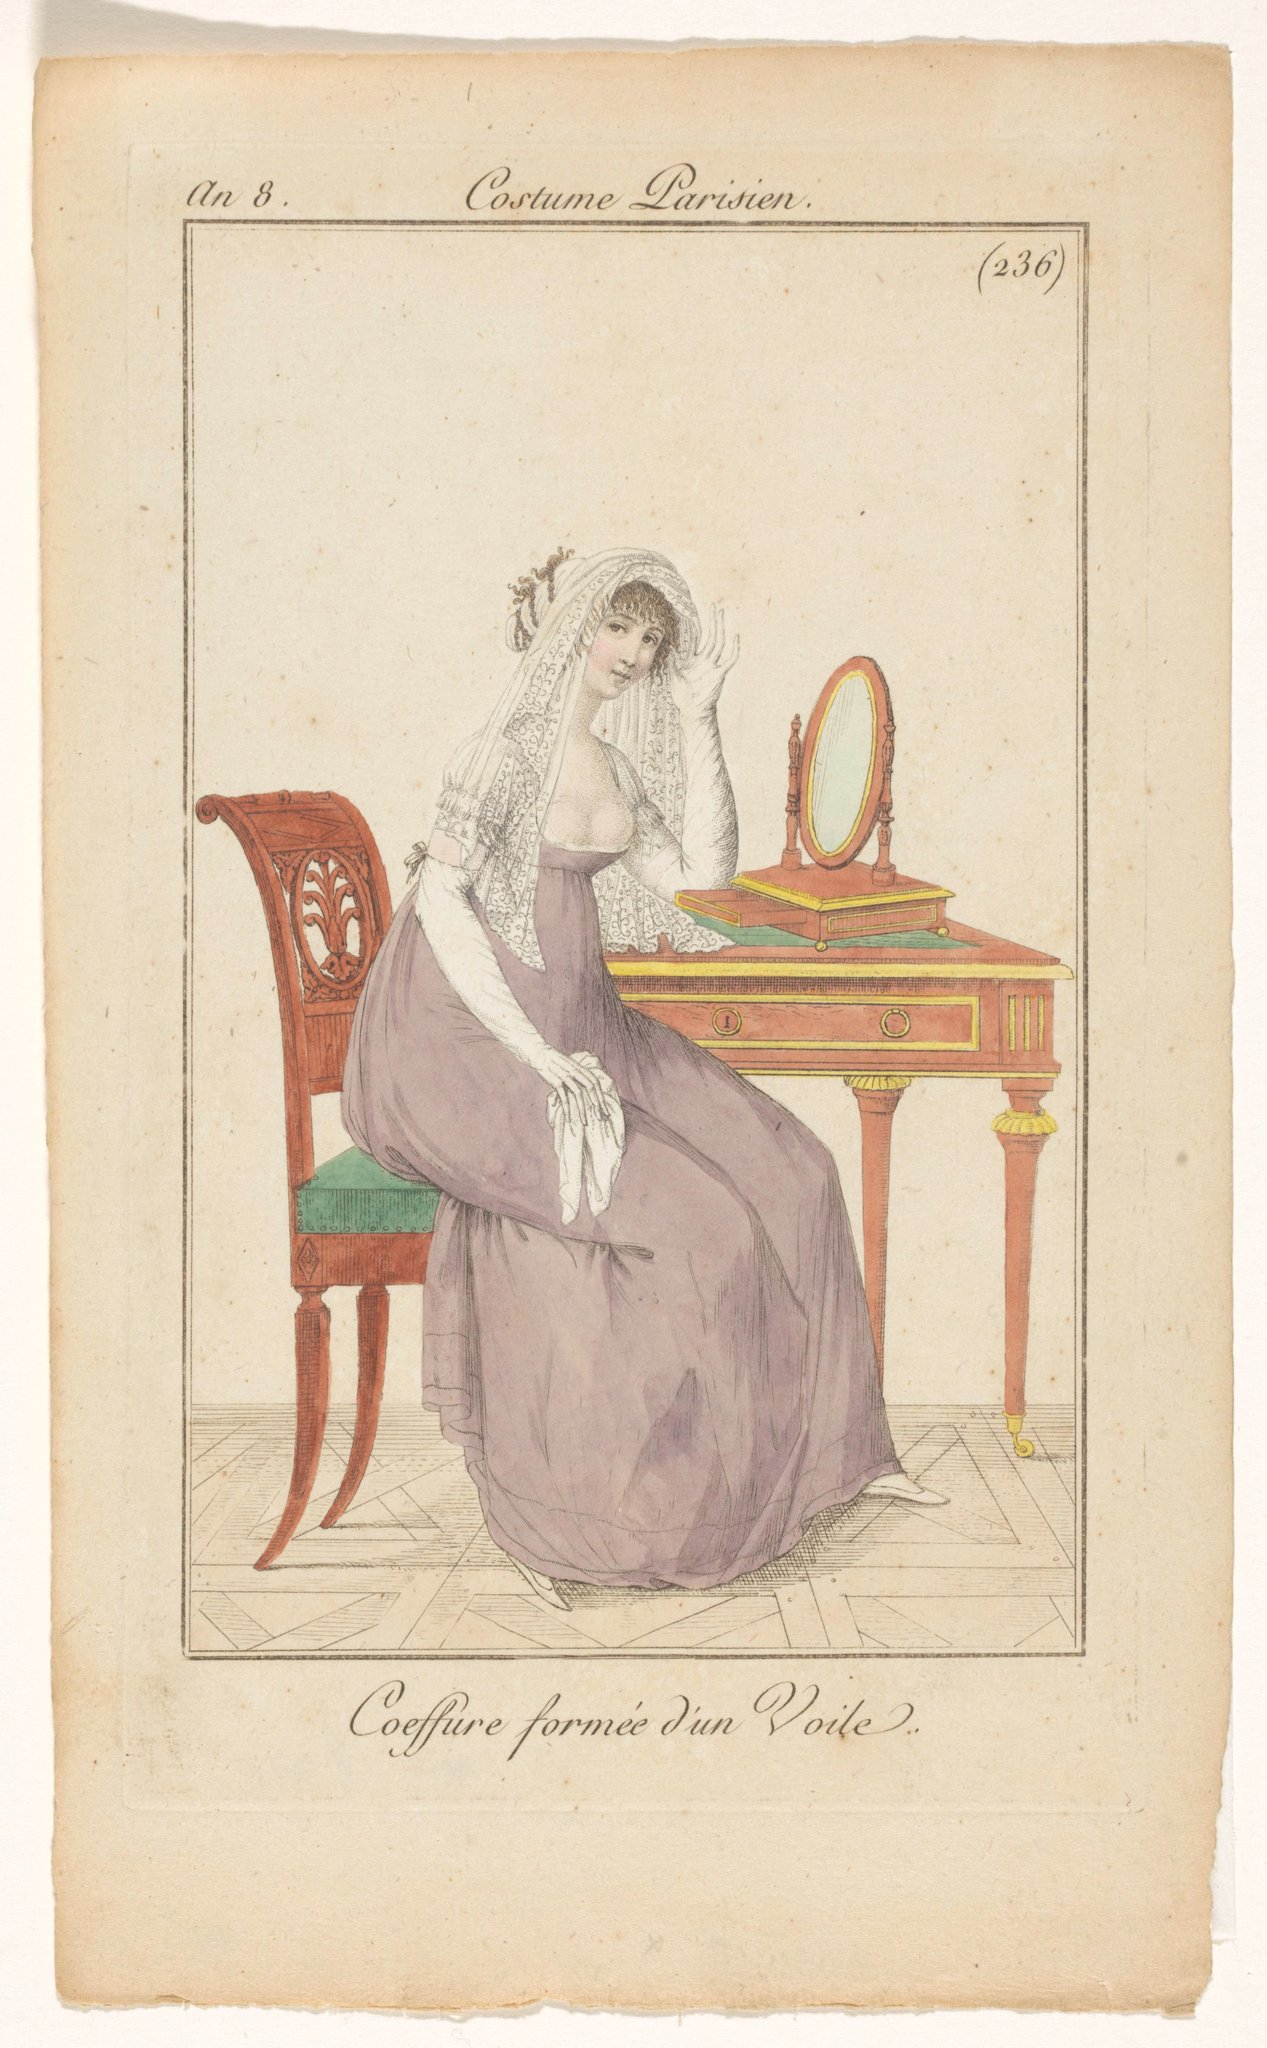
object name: fashion print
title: Jonge vrouw met sluier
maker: Anonymous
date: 1799-1801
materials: paper, ink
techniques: etching, hand coloring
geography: france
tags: making toilet, fashion plates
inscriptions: collector's mark: Lugt 2228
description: Jonge vrouw met sluier, toiletmakend aan tafeltje. Prent genomen uit het modetijdschrift Journal des Dames et des Modes, Costume Parisien, An 8 [1799-1800], nr. 236.